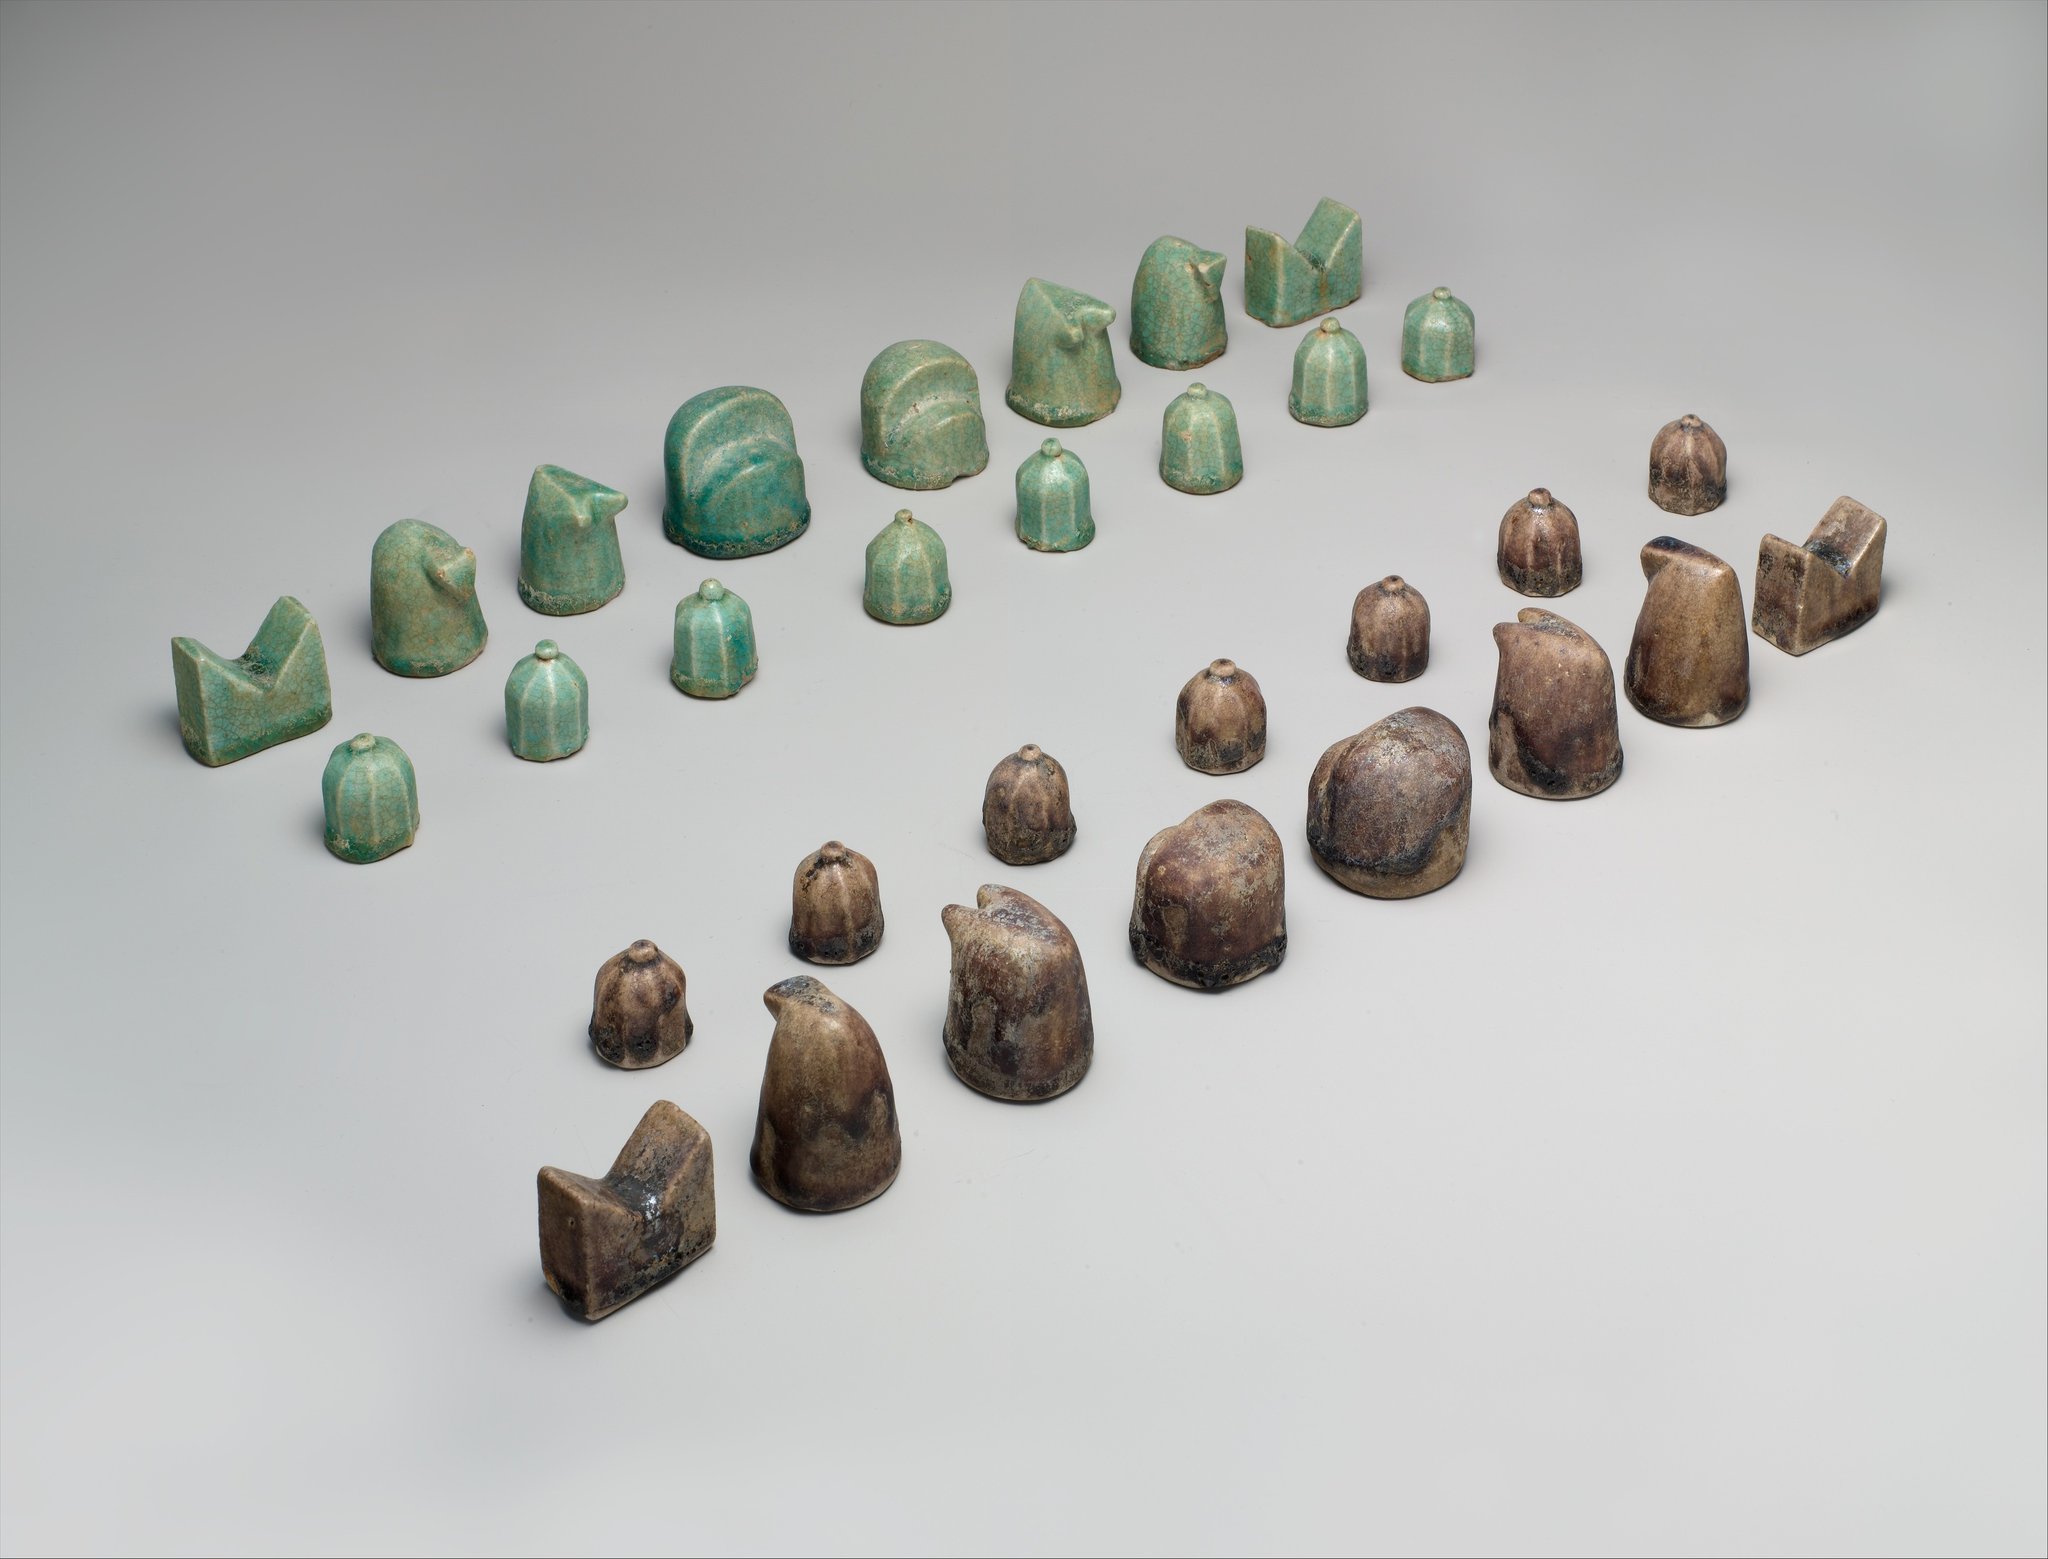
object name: chess set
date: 1101-1200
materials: stonepaste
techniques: glazing, molding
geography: iran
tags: chess,games